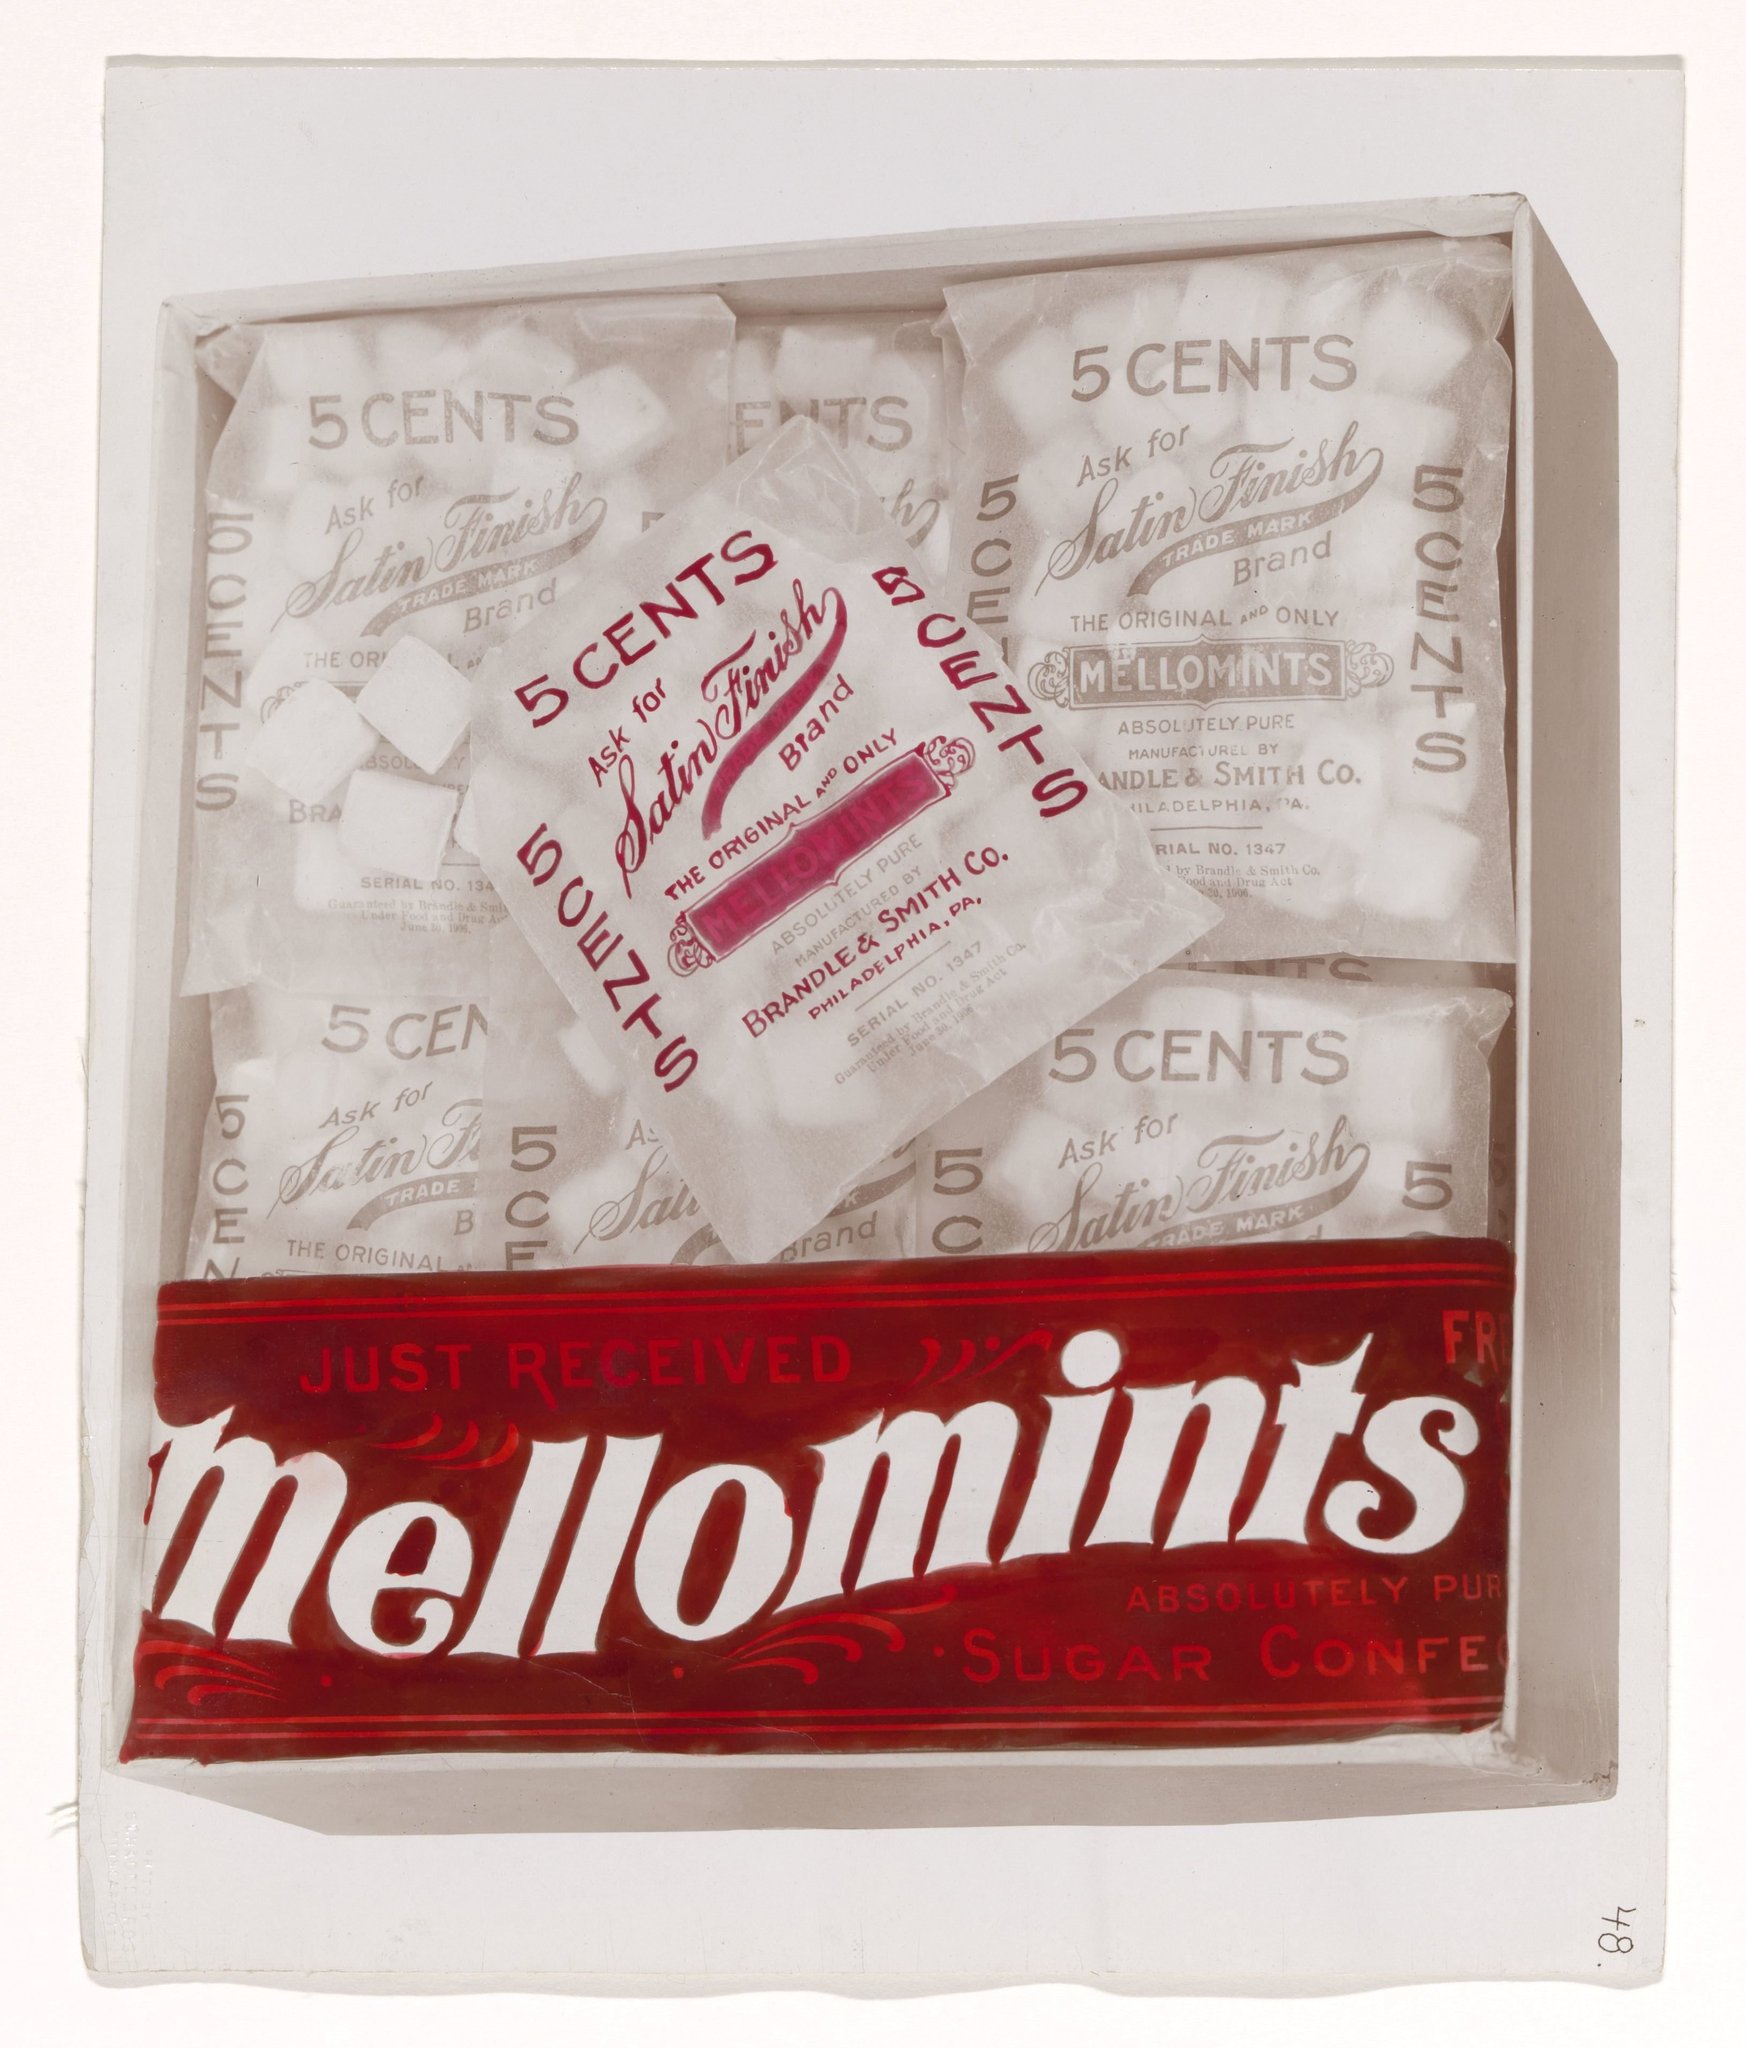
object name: photograph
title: 'Mellomints', Packet of 'Candies' Sold by Brandle & Smith Company, Philadelphia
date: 1915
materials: paper, paint, textile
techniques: hand coloring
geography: minneapolis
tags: advertising, sugar-candy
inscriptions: number: ‘48.’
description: Reclame voor snoepfabrikant Brandle & Smith Co., Philadelphia.